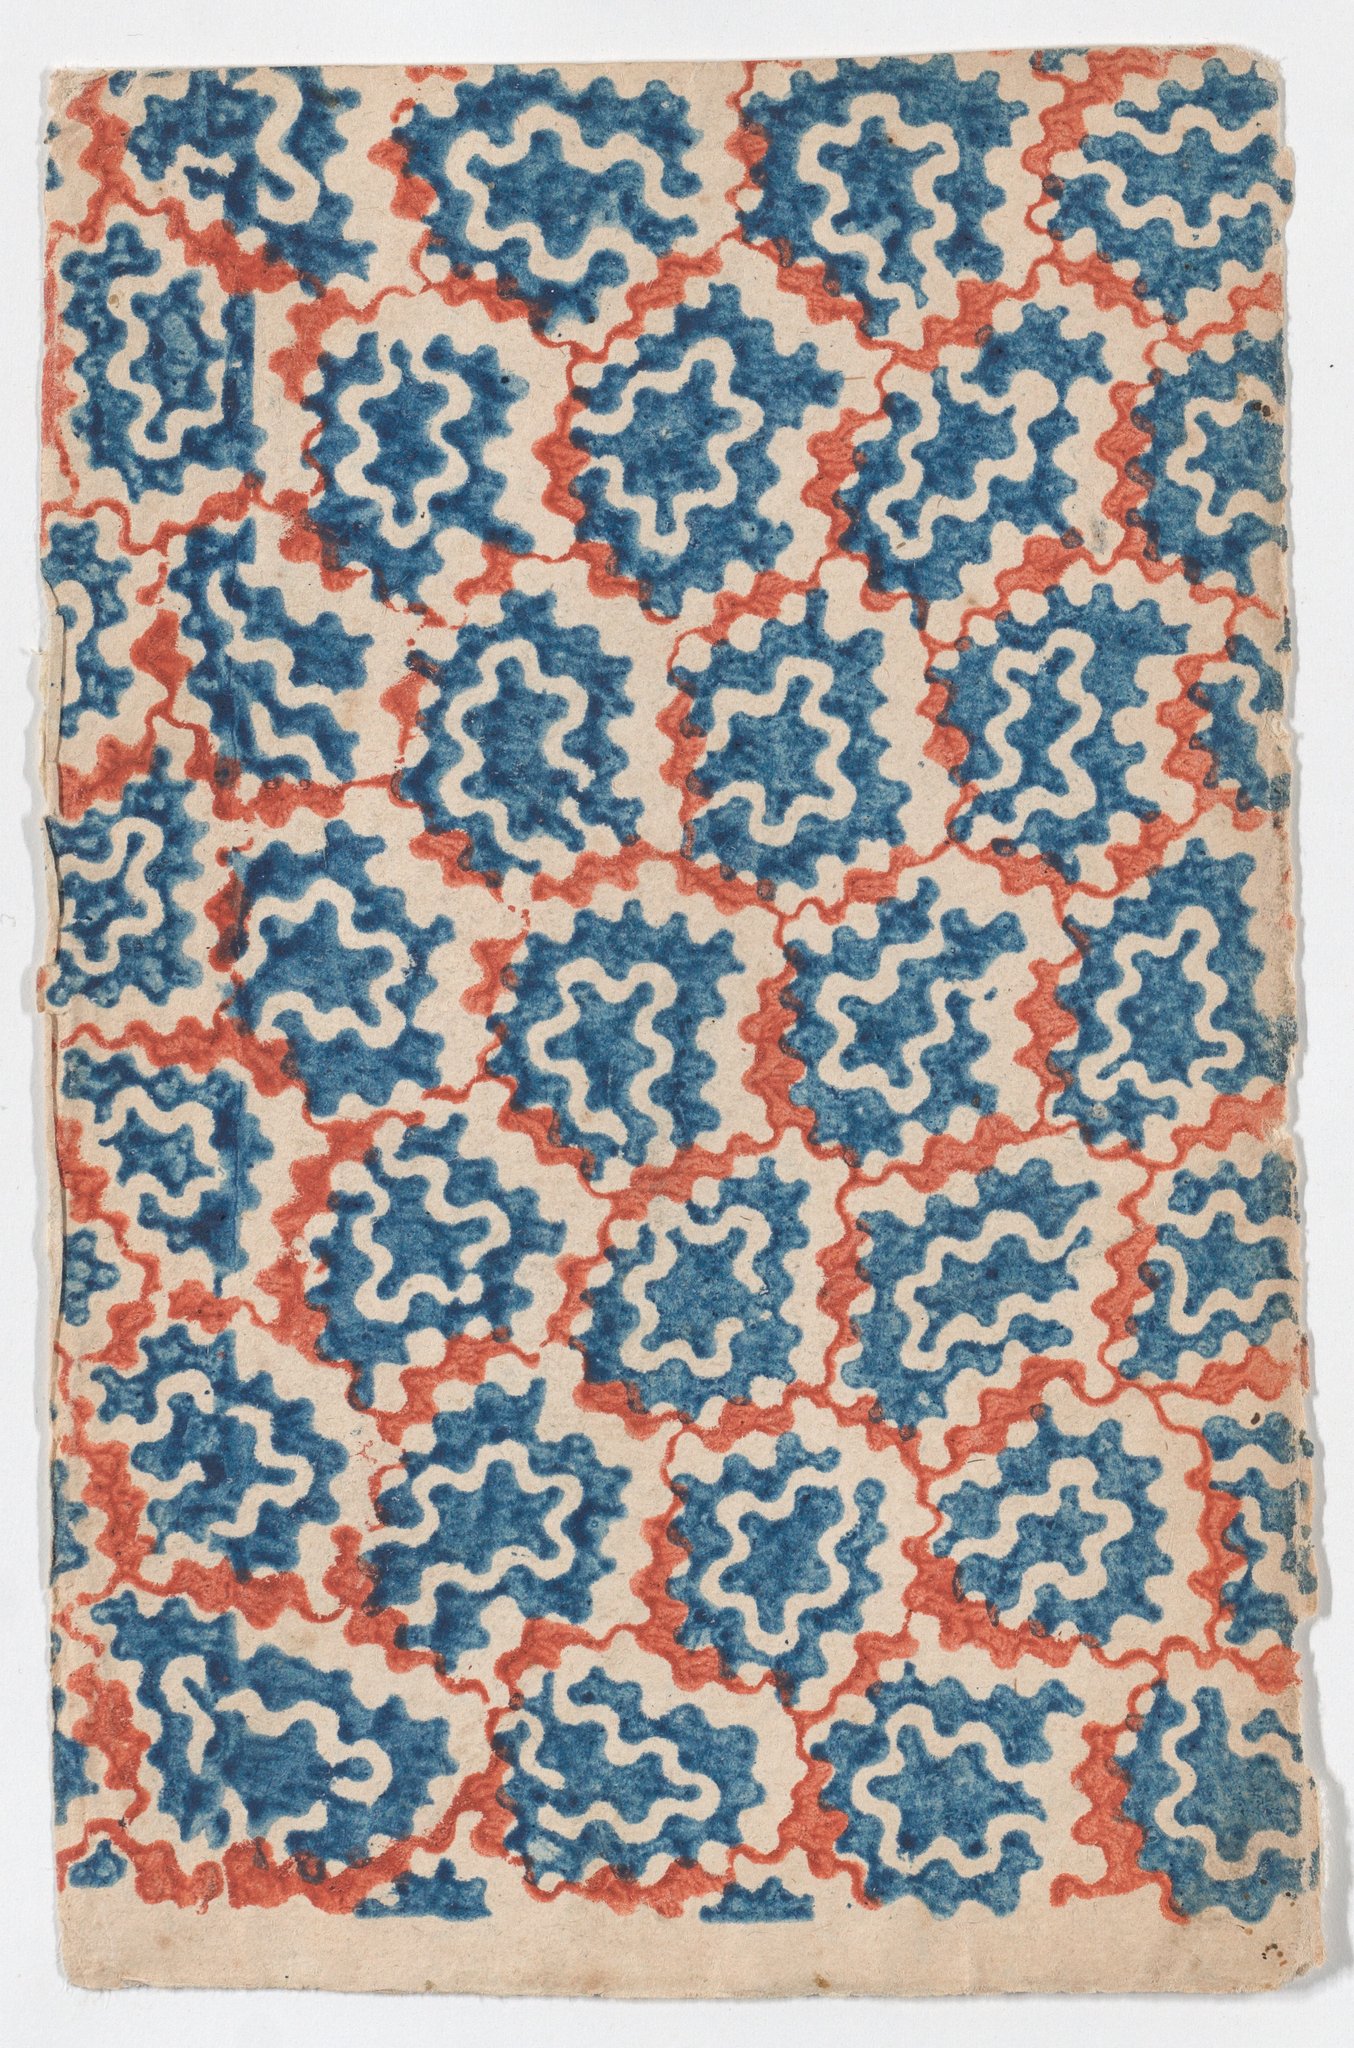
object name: print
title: Sheet with an overall pattern of organic shapes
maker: Anonymous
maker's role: artist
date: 1801-1900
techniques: relief print